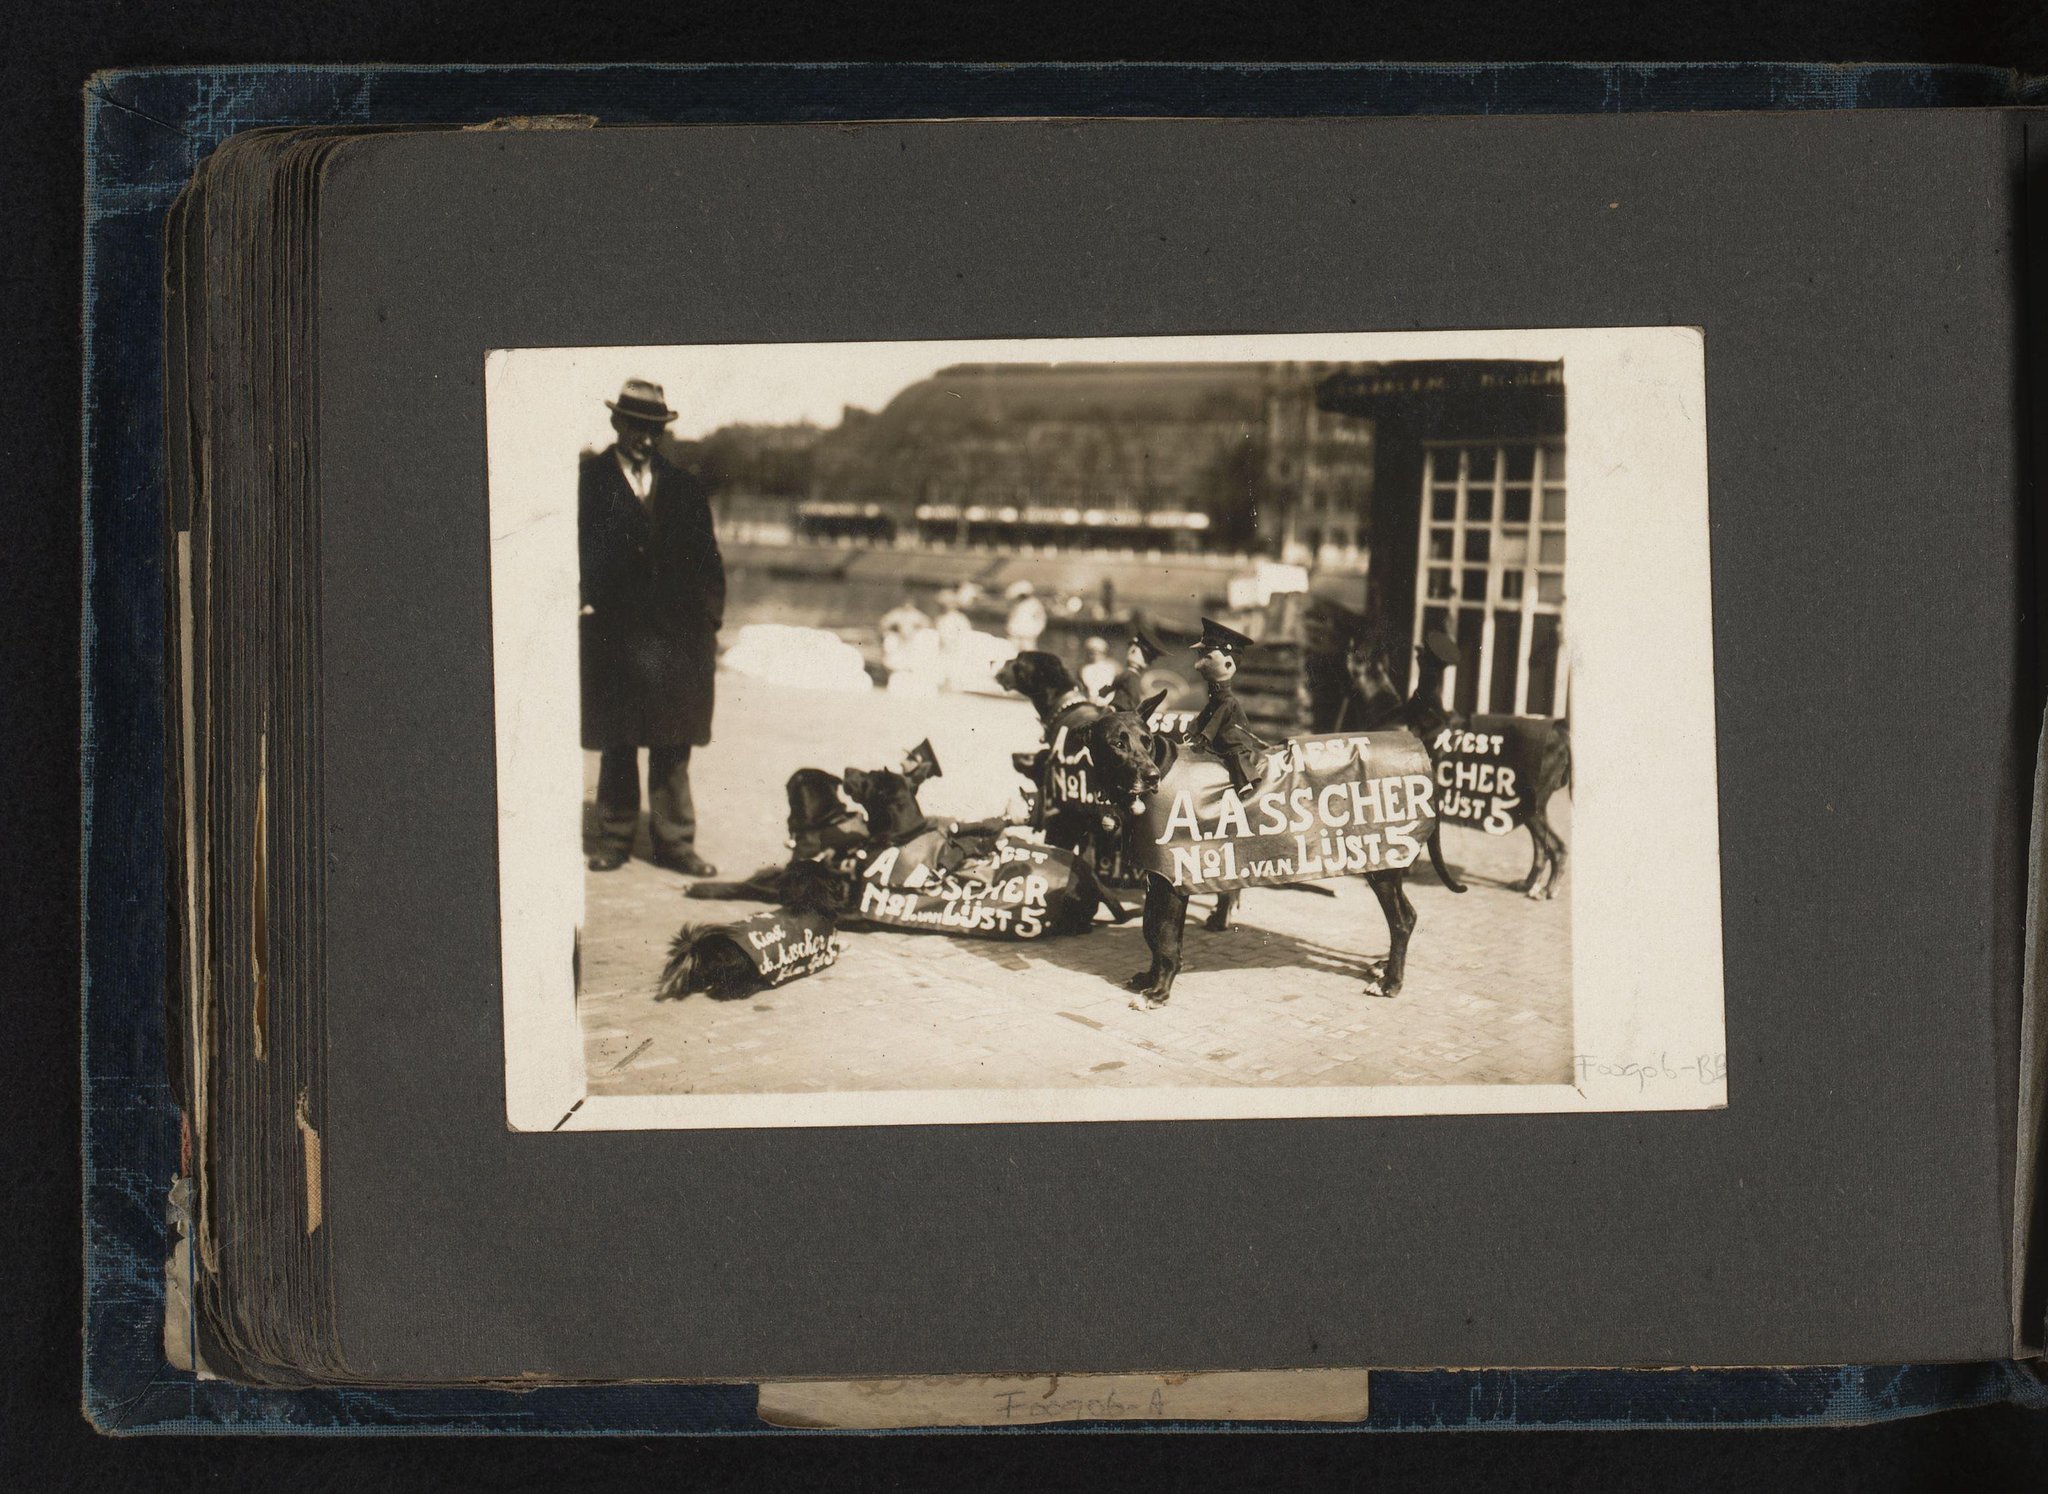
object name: album leaf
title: Honden van de poppendokter met reclameteksten van Asscher, lijst 5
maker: Anonymous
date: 1930-1940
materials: photographic support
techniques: gelatin silver print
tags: advertising, historical persons, dog